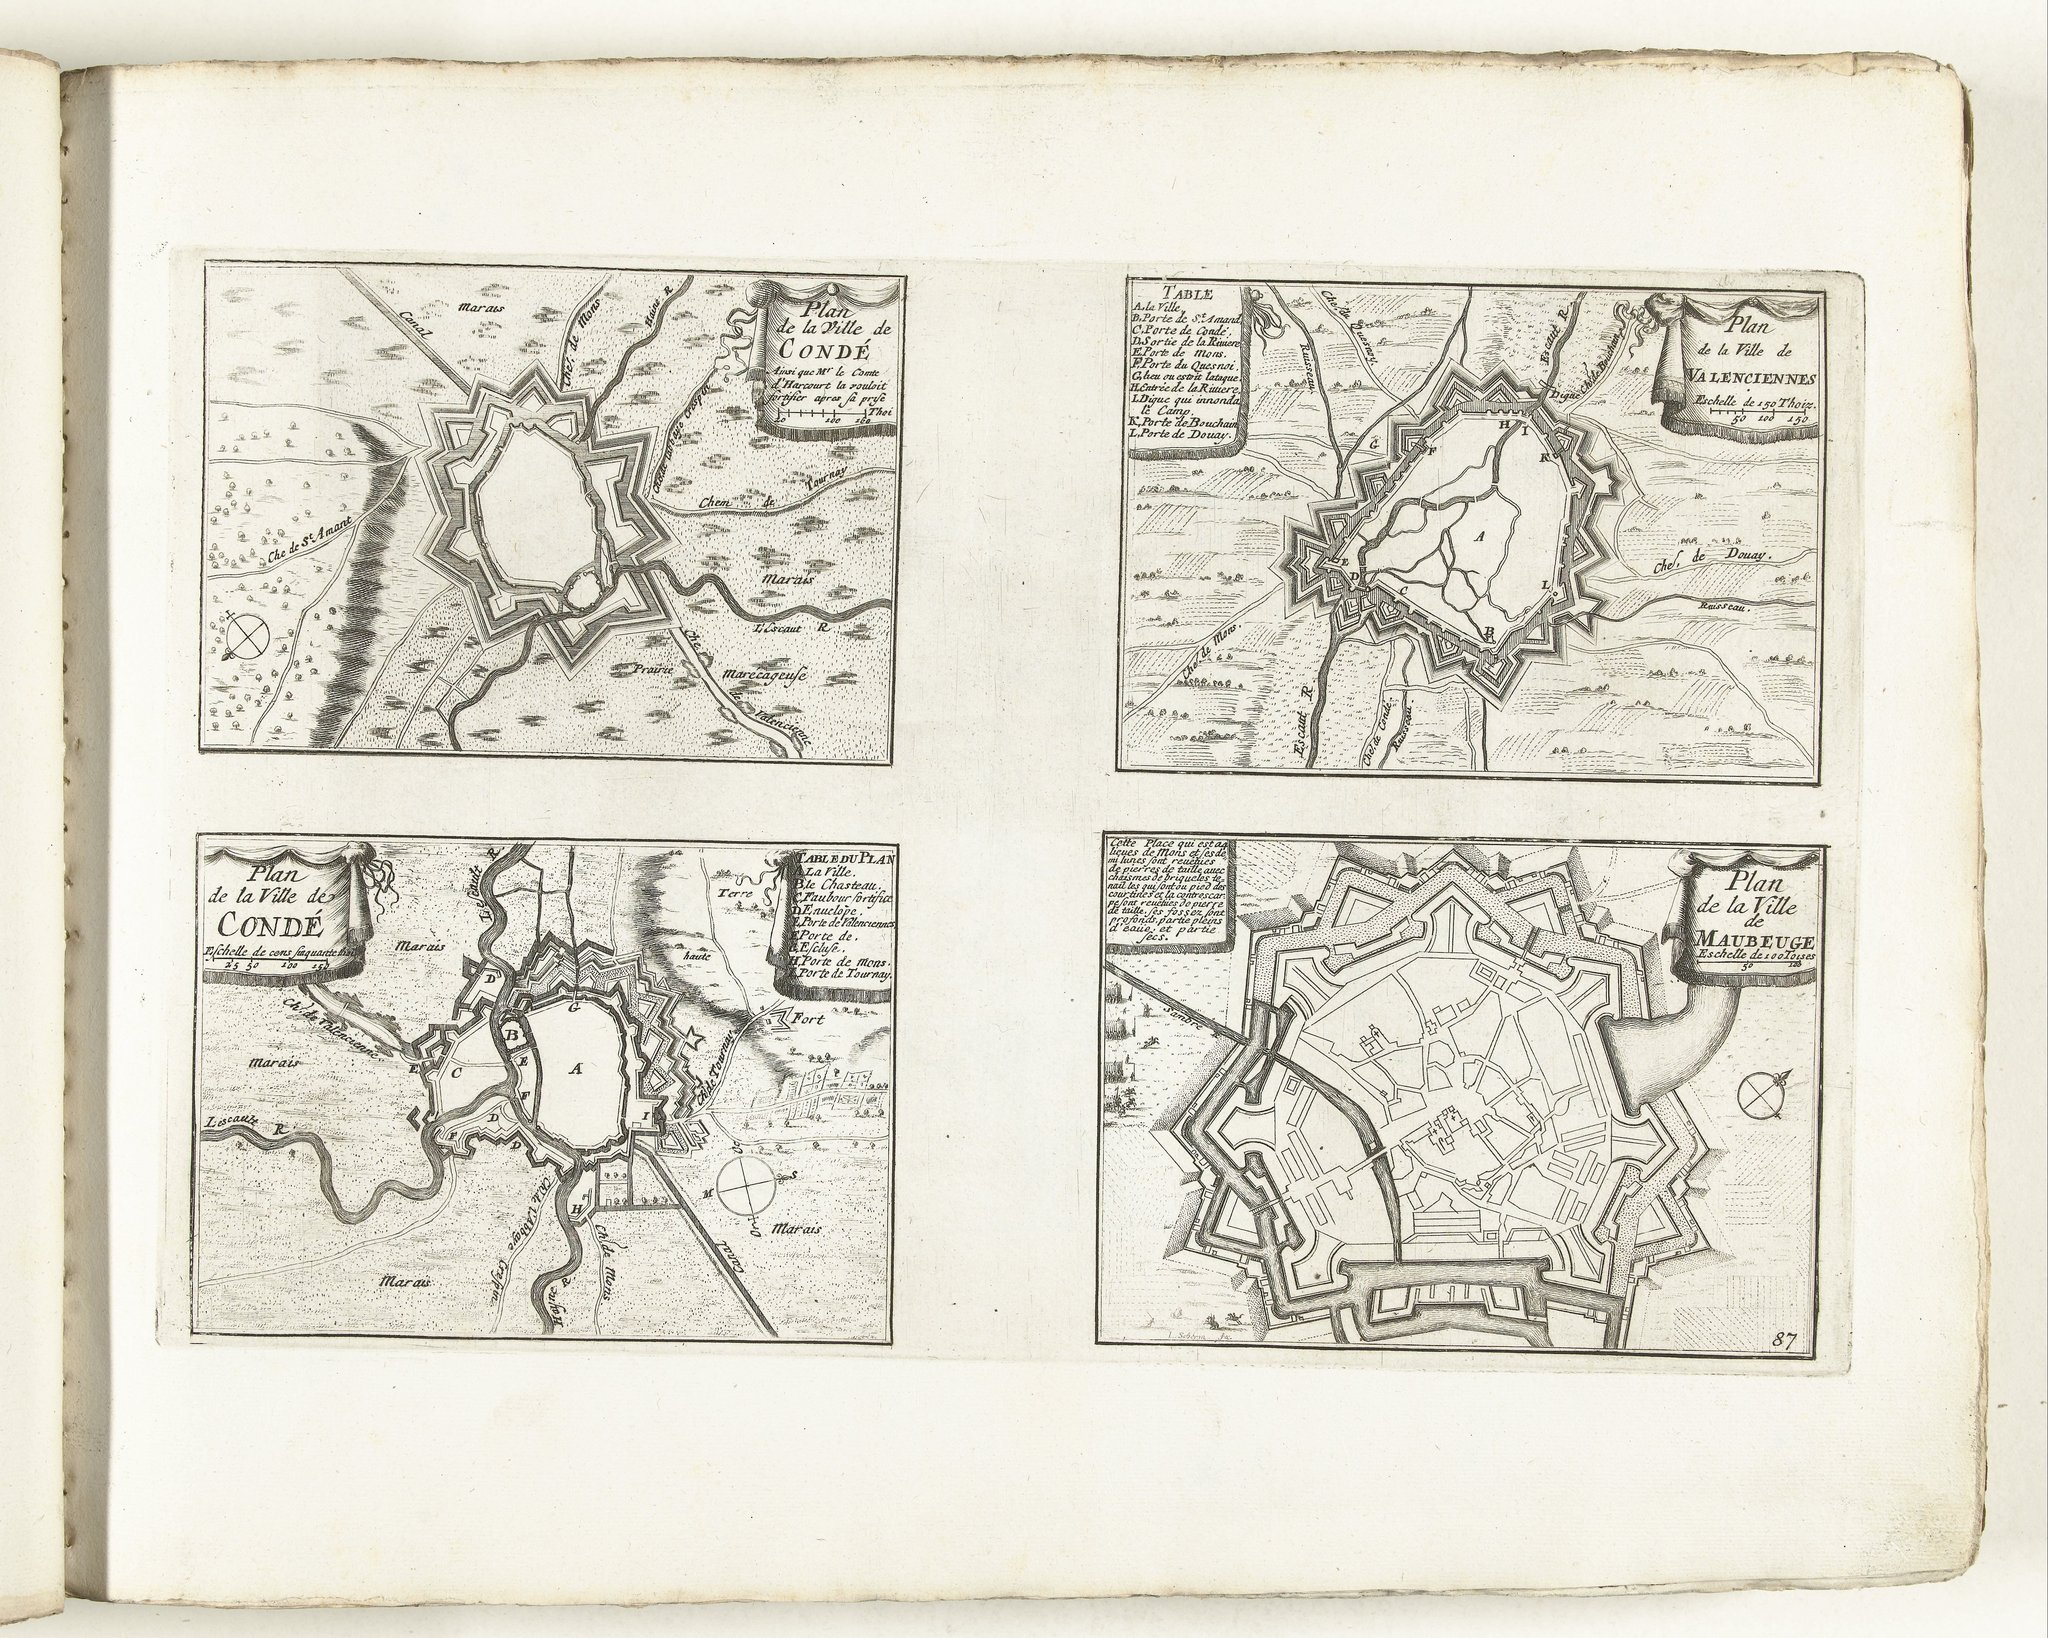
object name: print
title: Les Forces de l'Europe, Asie, Afrique et Amerique, ou description des principales villes avec leurs fortifications. Dessignées par les meilleurs ingenieurs, particulierement celles qui sont sous la domination de la France (...) et ornées de plusieurs superbes edifices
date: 1702-1703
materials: paper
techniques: engraving, etching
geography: amsterdam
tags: fortress, maps of cities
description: Blad met vier plattegronden van de versterkingen om de steden Condé (twee keer), Valenciennes en Maubeuge. Plaat nr. 87 in het prentwerk bestaande in totaal uit 276 genummerde platen van vermaarde sterke steden en vestingen in het kader van de Spaanse Successieoorlog. Voor het merendeel zijn deze platen gekopieerd naar de anonieme Franse platen: in Les forces de l'Europe en in: Le theatre de la guerre, dans les Pays-Bas, beide oorspronkelijk uitgegeven door Nicolas de Fer te Parijs (1693-1697) in het kader van de Negenjarige Oorlog. Titels en opschriften in de plaat in het Frans.